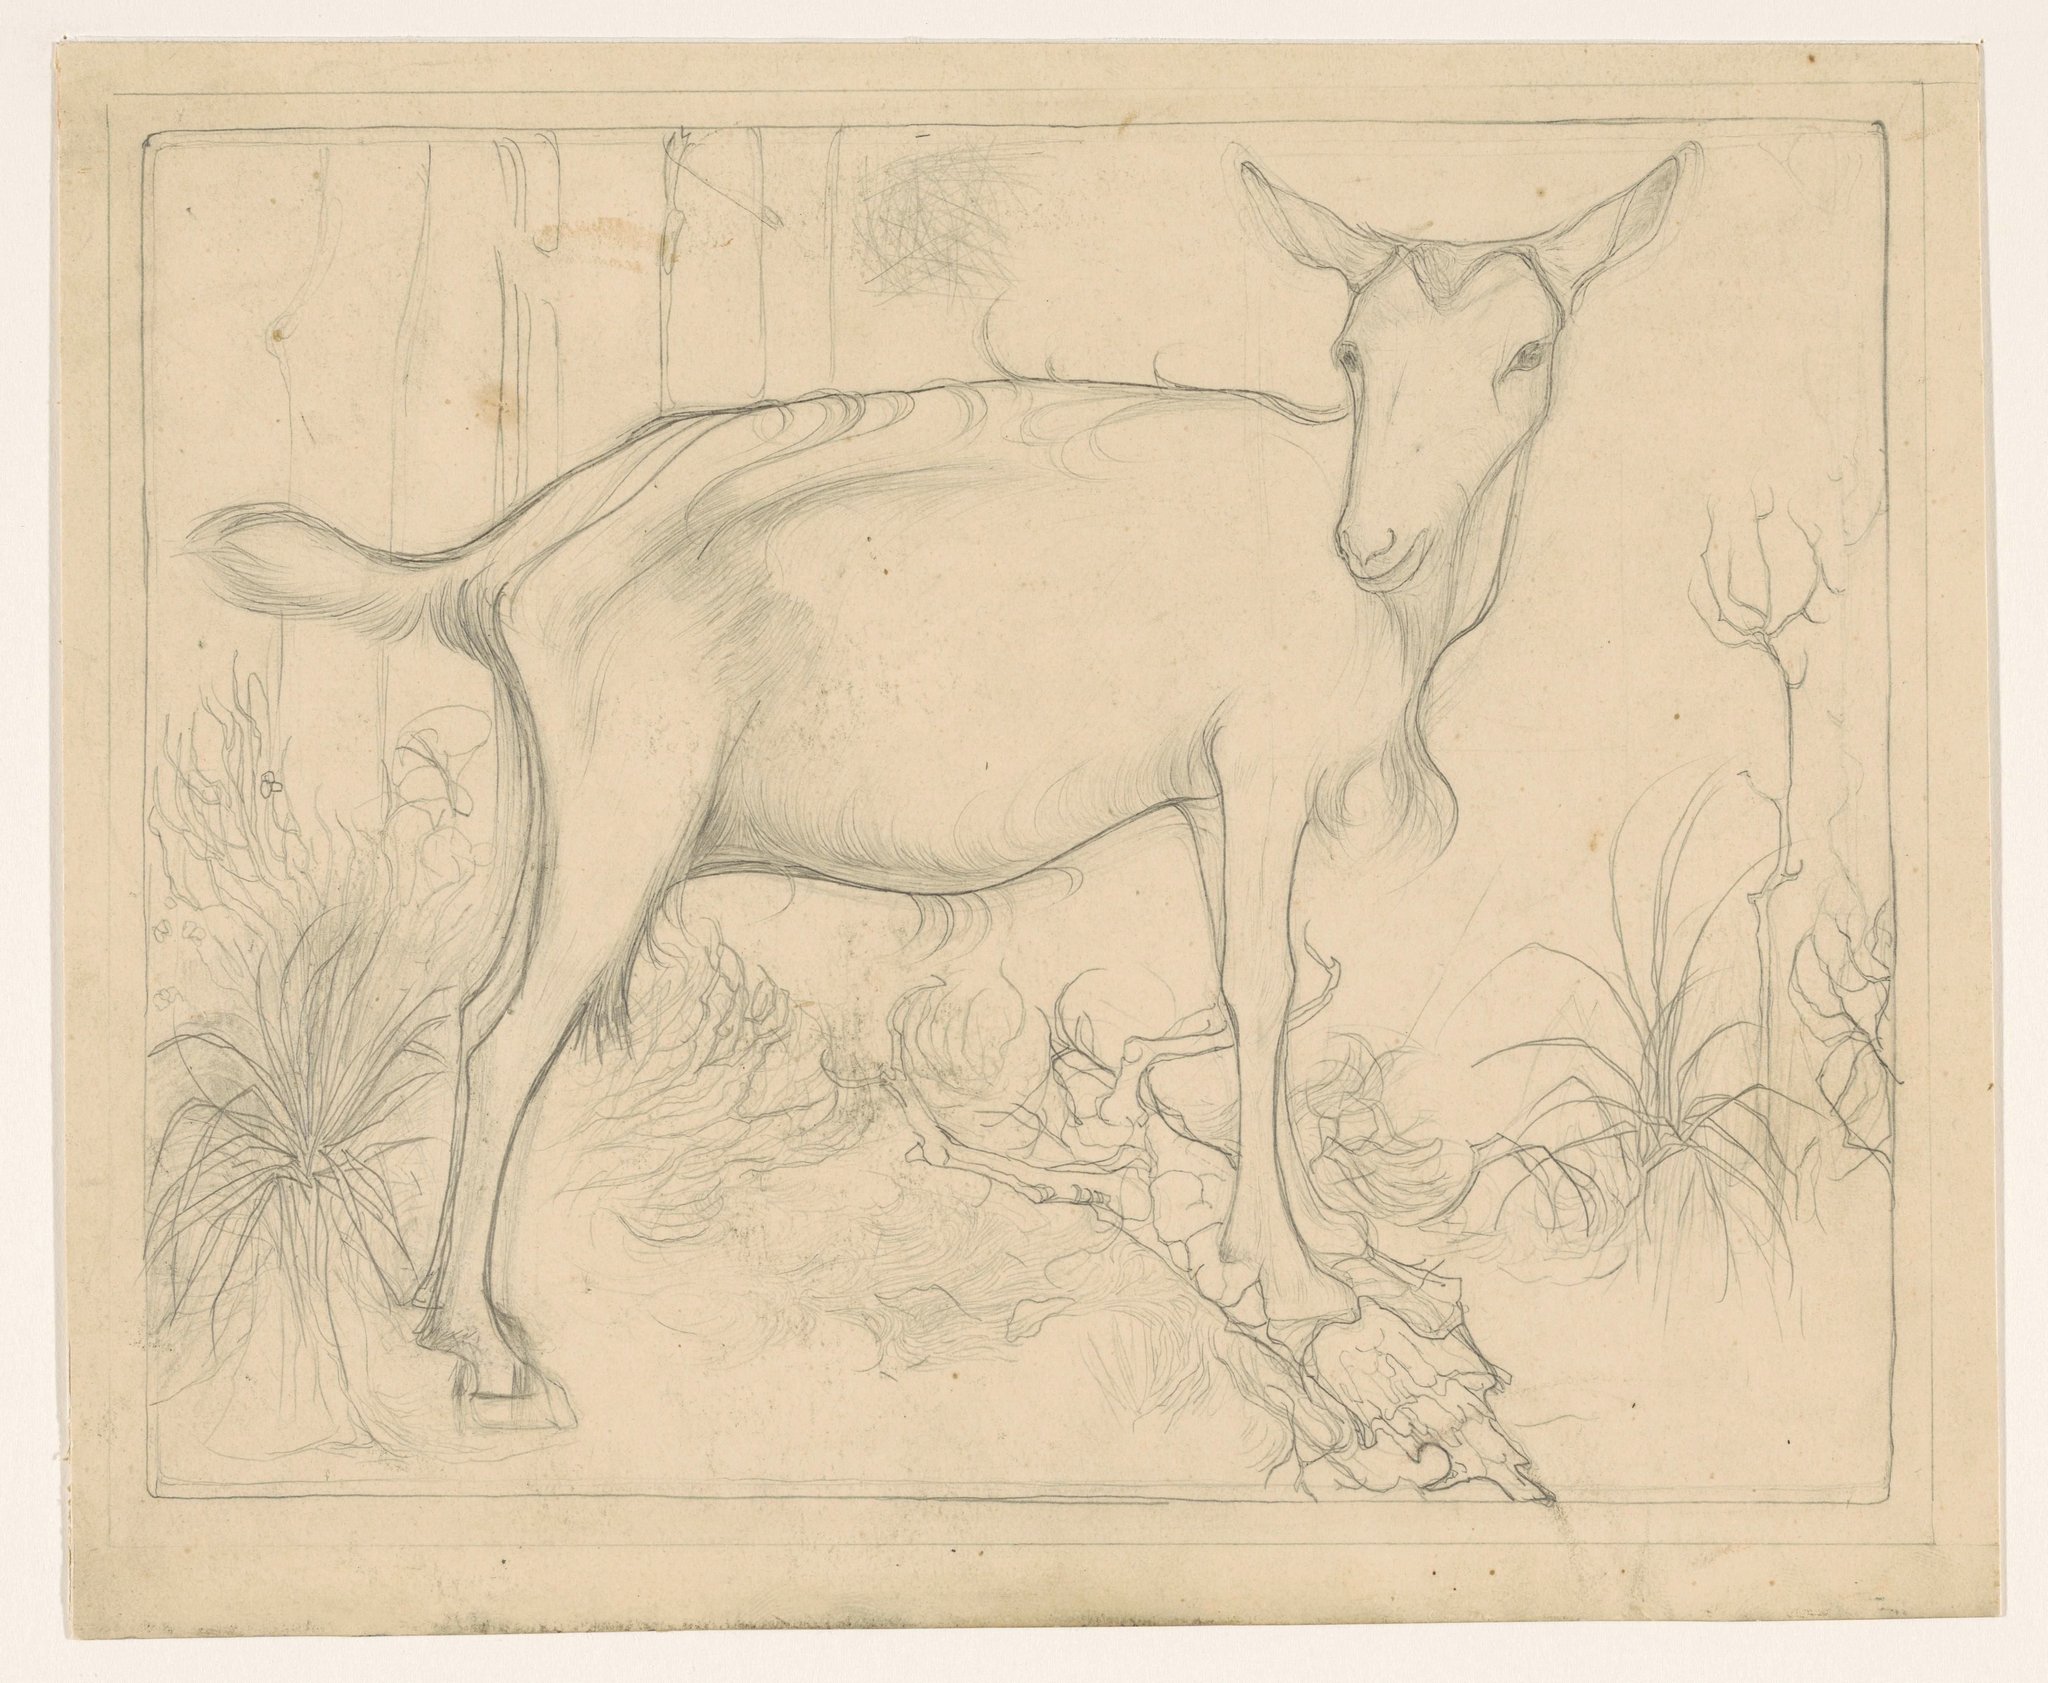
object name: design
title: Geit op een boomstam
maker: jan mankes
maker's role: draughtsman, painter, print maker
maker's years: 1889-1920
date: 1899-1920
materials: cardboard, pencil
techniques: pouncing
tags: goat